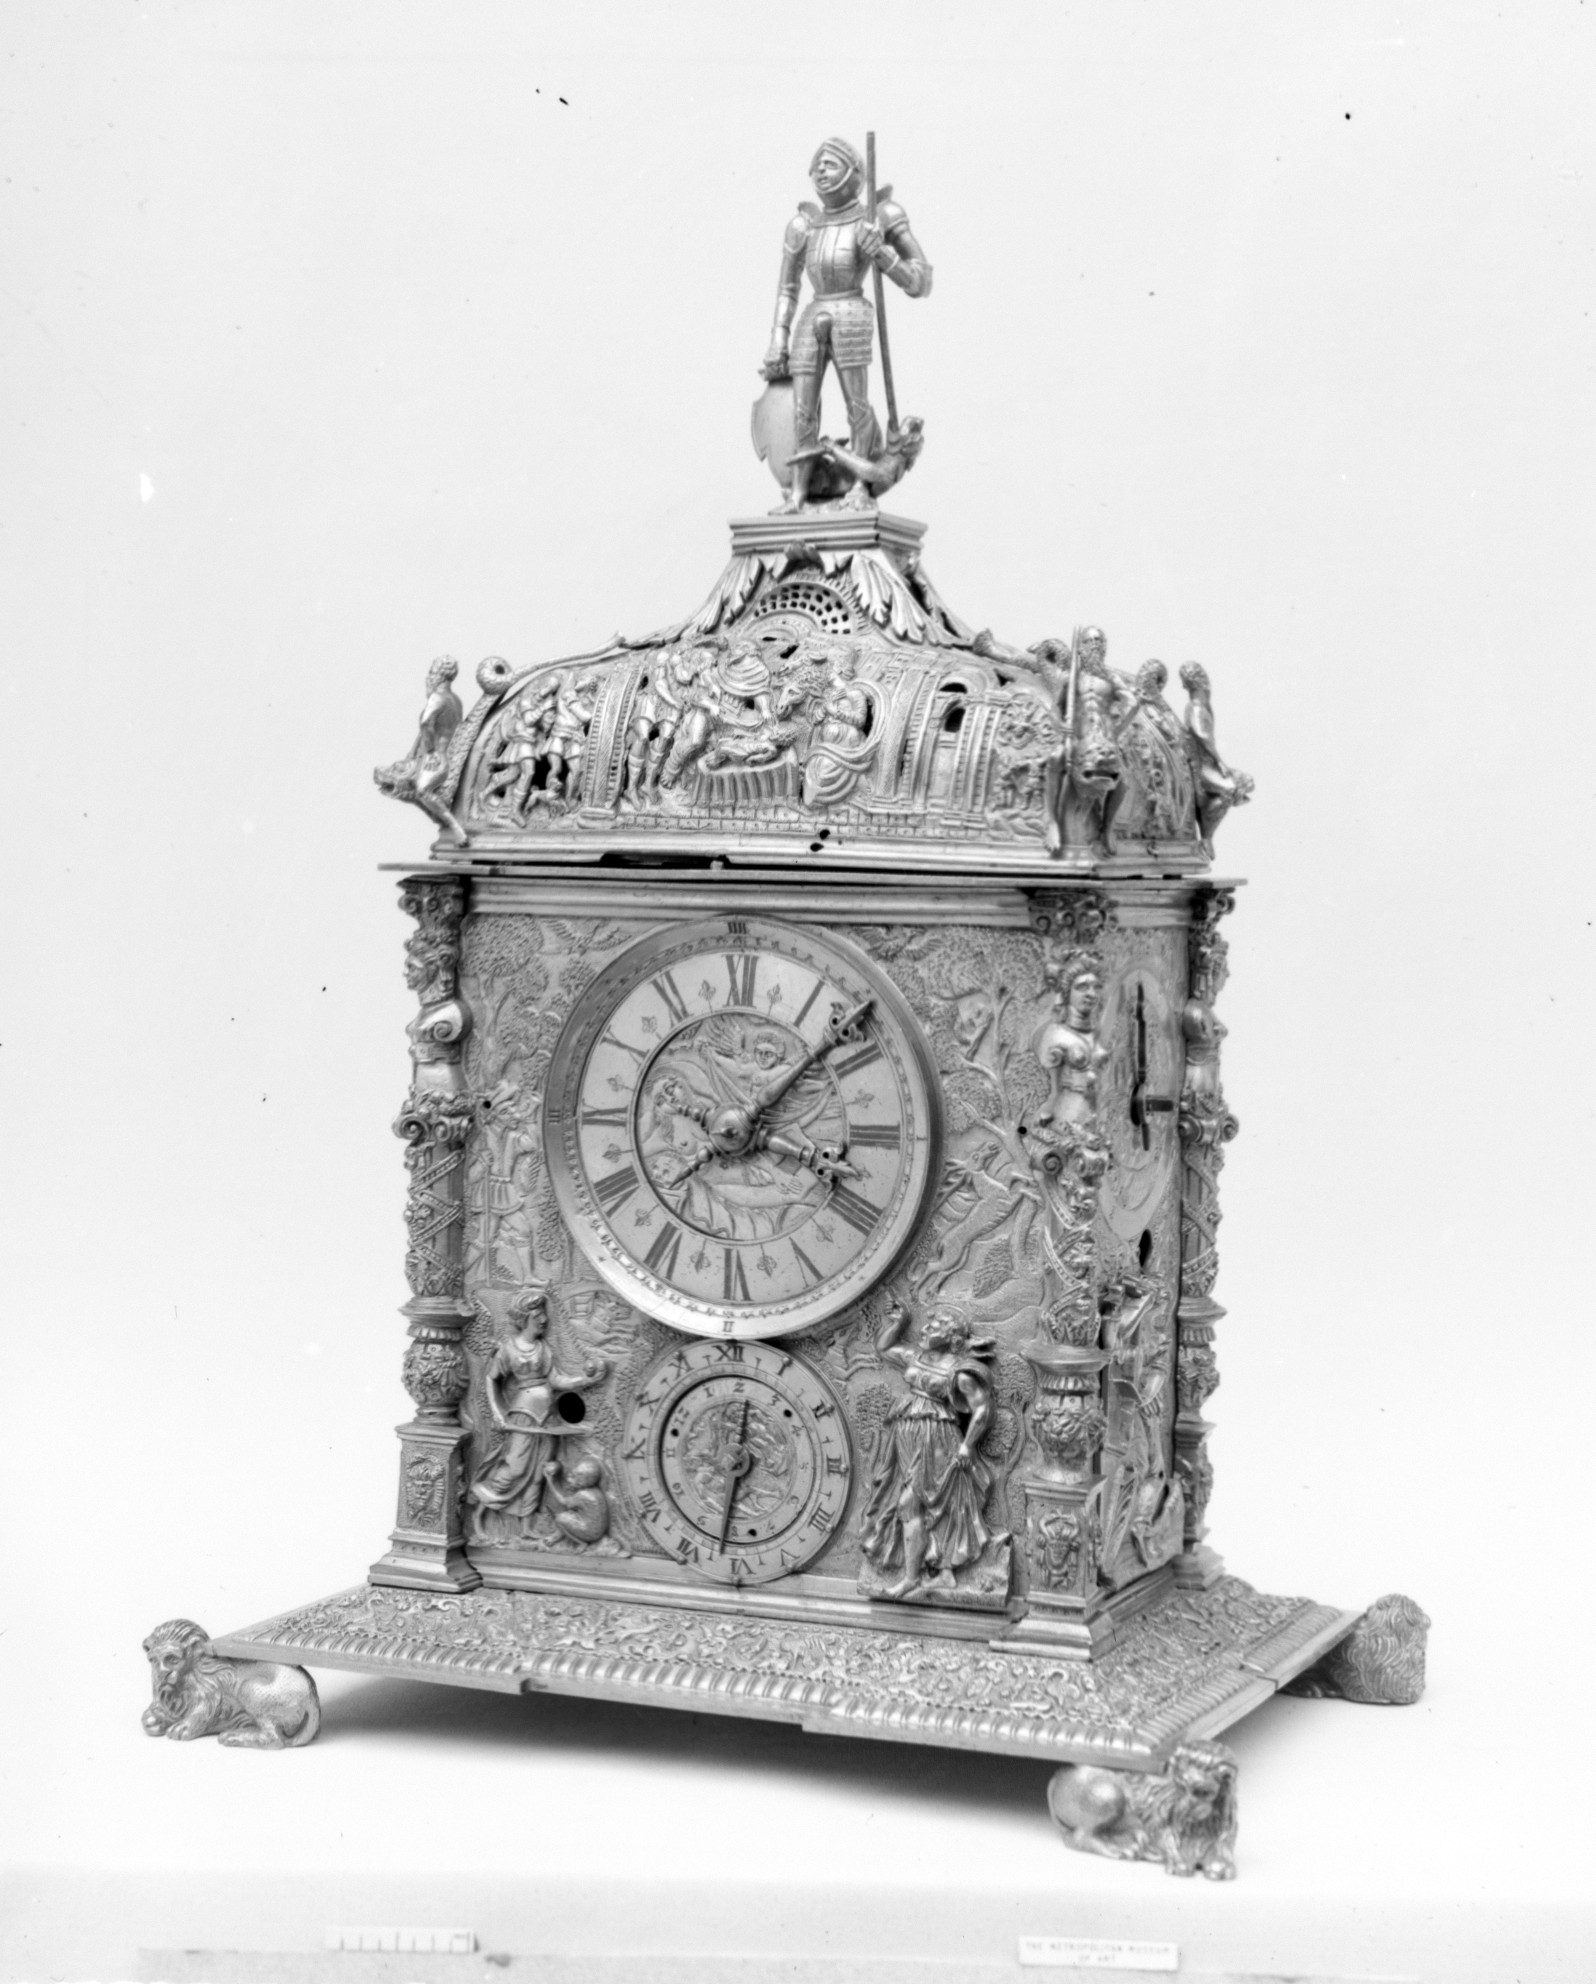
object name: clock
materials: gilt bronze, iron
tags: animals,female nudes,lions,saint george